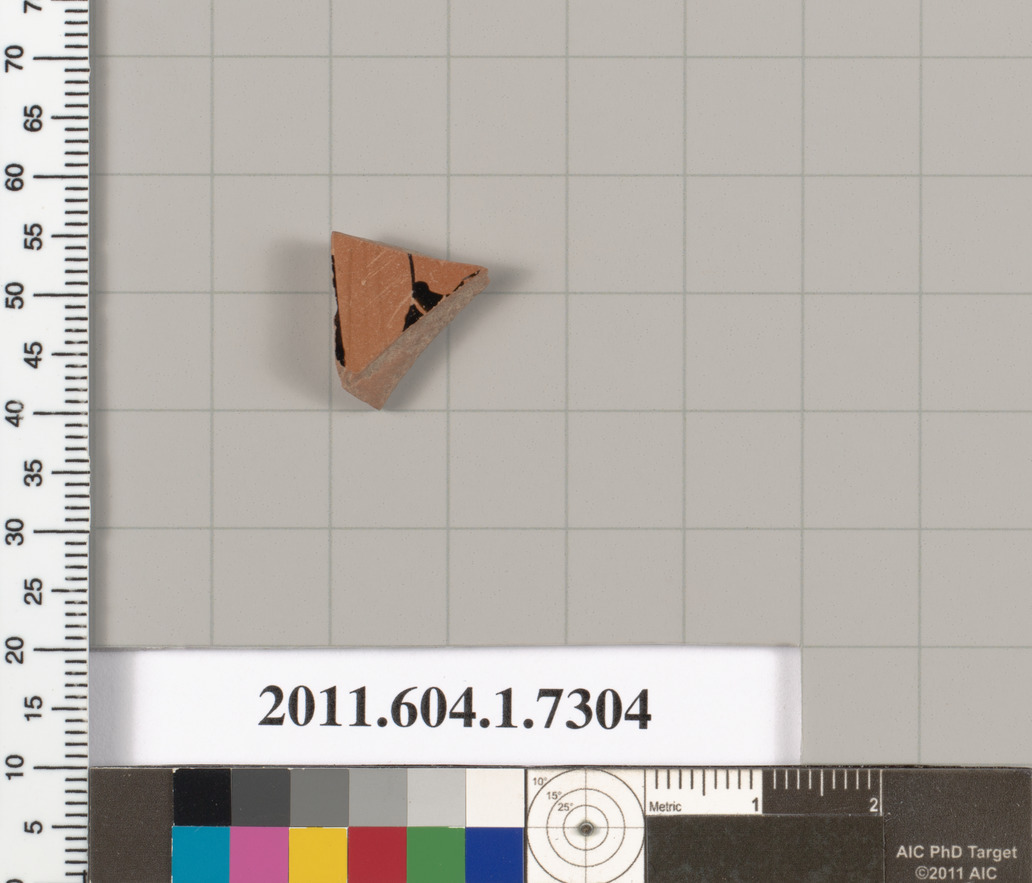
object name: kylix fragment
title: Terracotta fragment of a kylix (drinking cup)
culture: greek, attic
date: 500-480 BCE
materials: terracotta